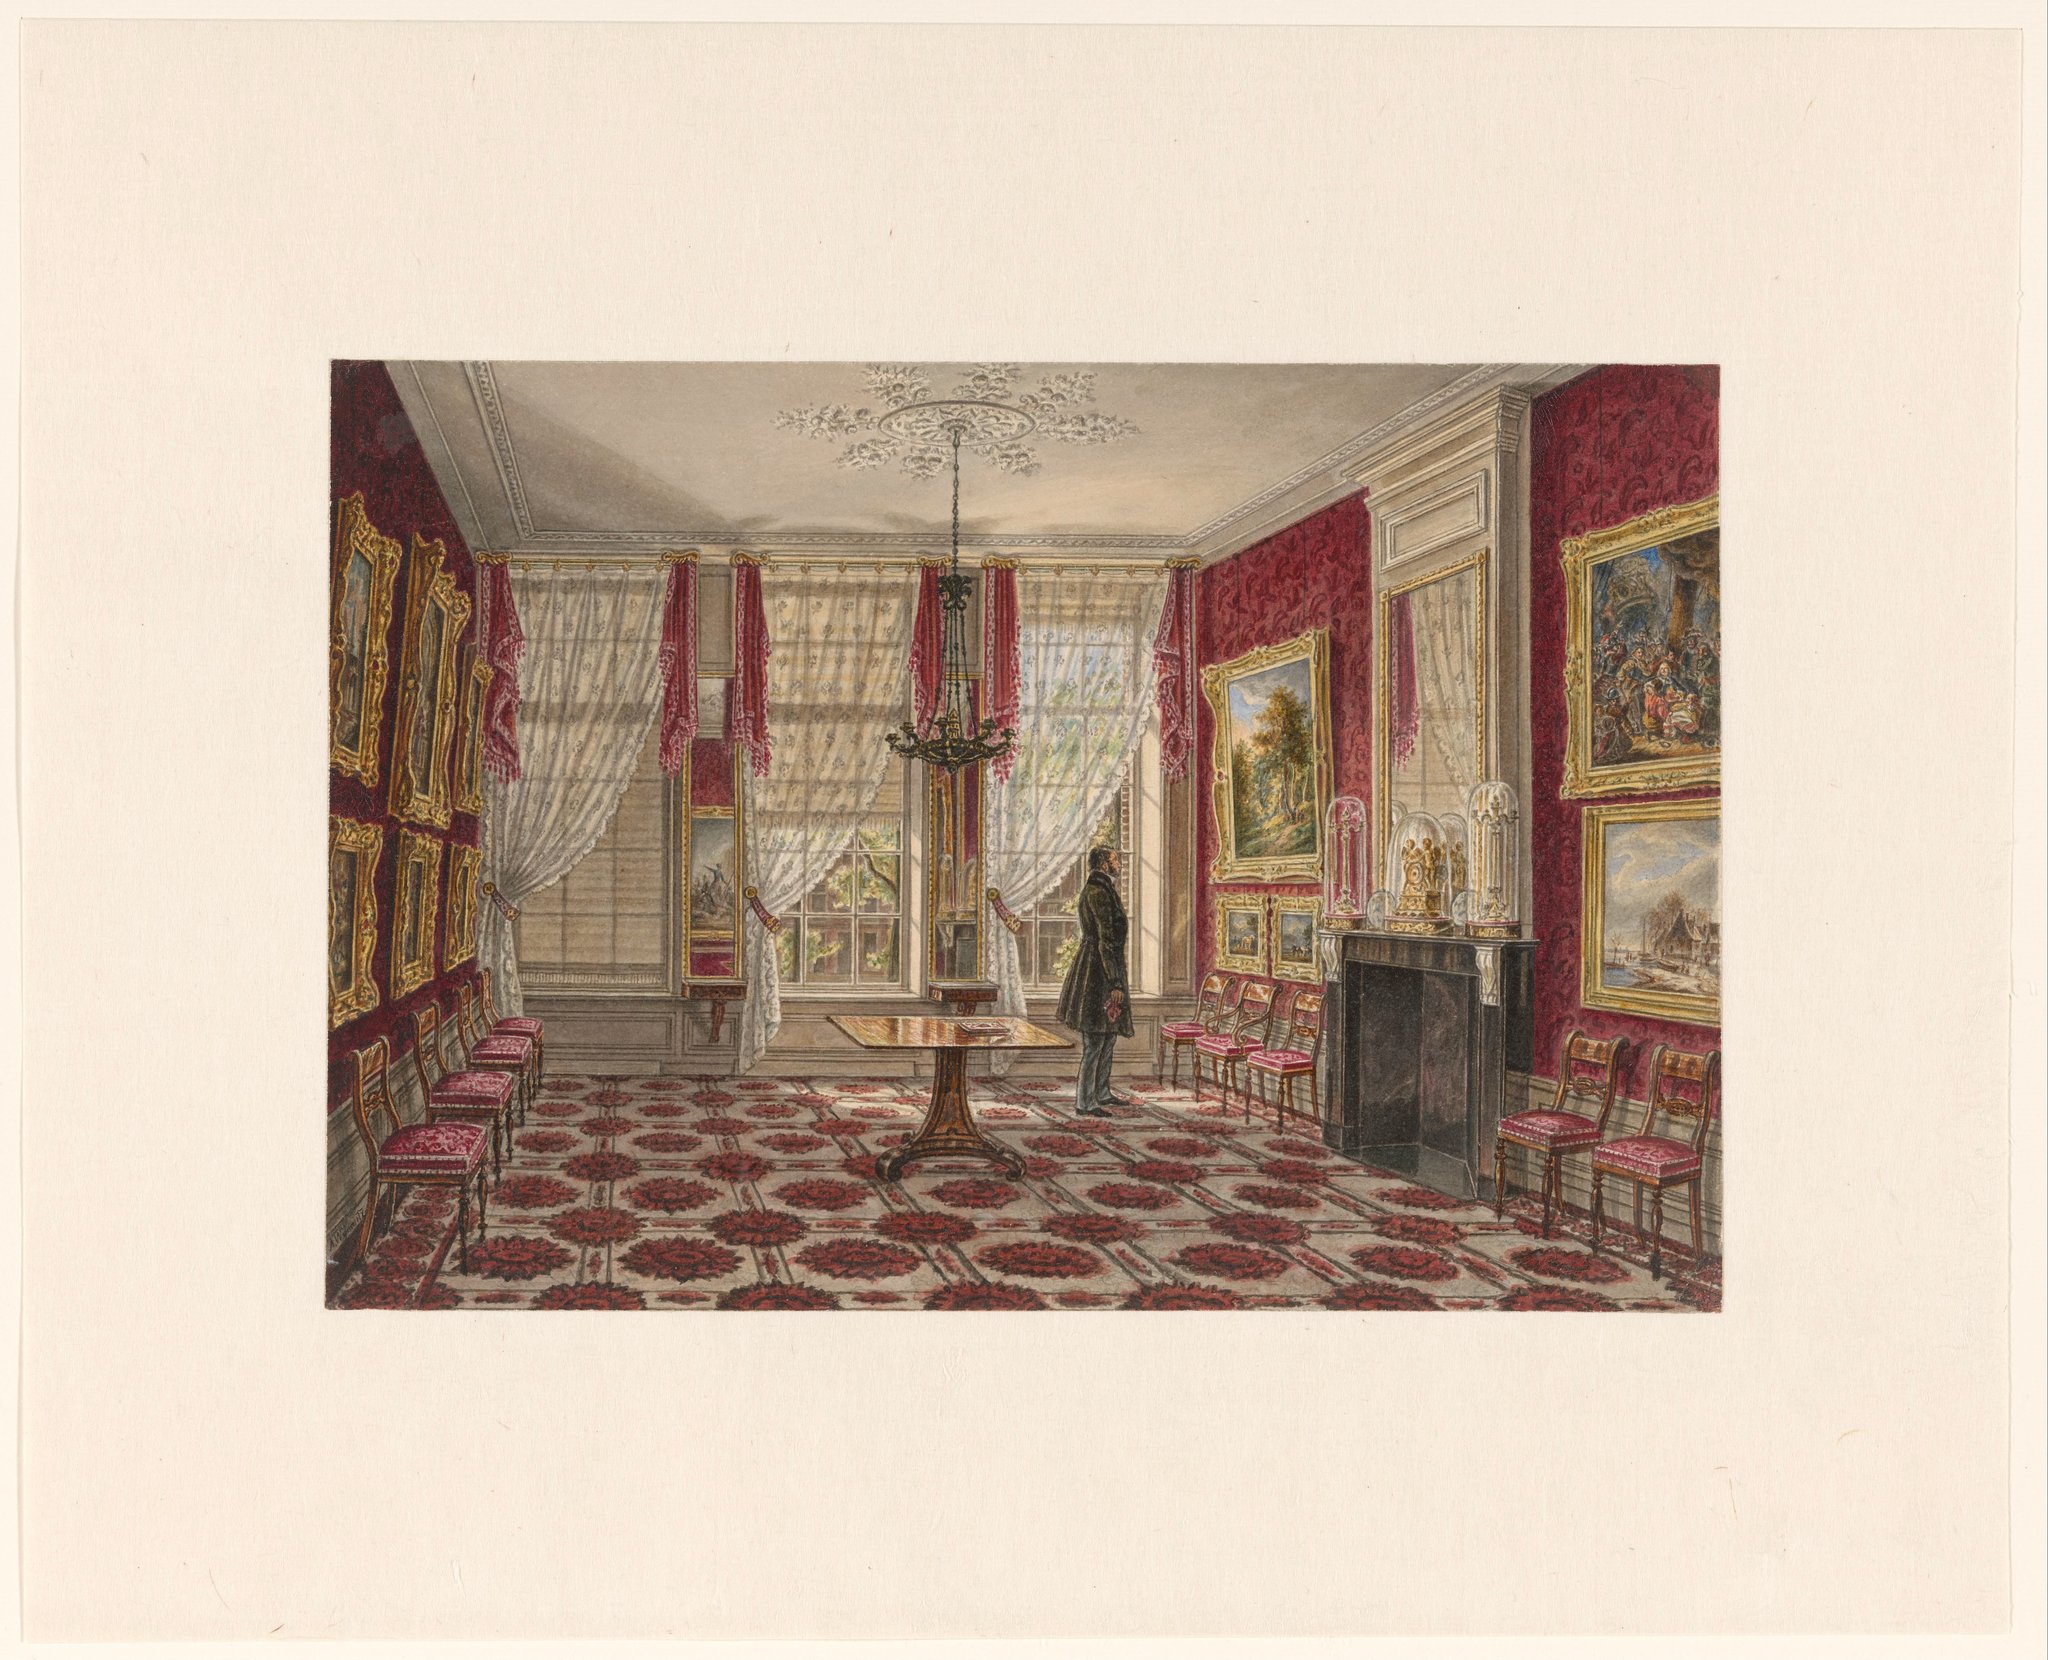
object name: drawing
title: 19e eeuws interieur met schilderijen en staande figuur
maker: augustus wijnantz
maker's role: draughtsman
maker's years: 1795-1848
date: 1842-1848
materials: gouache, paper, watercolor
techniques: brush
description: Gekleurde tekening van rijk gedecoreerd interieur met verschillende schilderijen. Voor het raam rechts bestudeert een staande man een van de schilderijen. Vermoedelijk kamer in paleis Noordeinde.